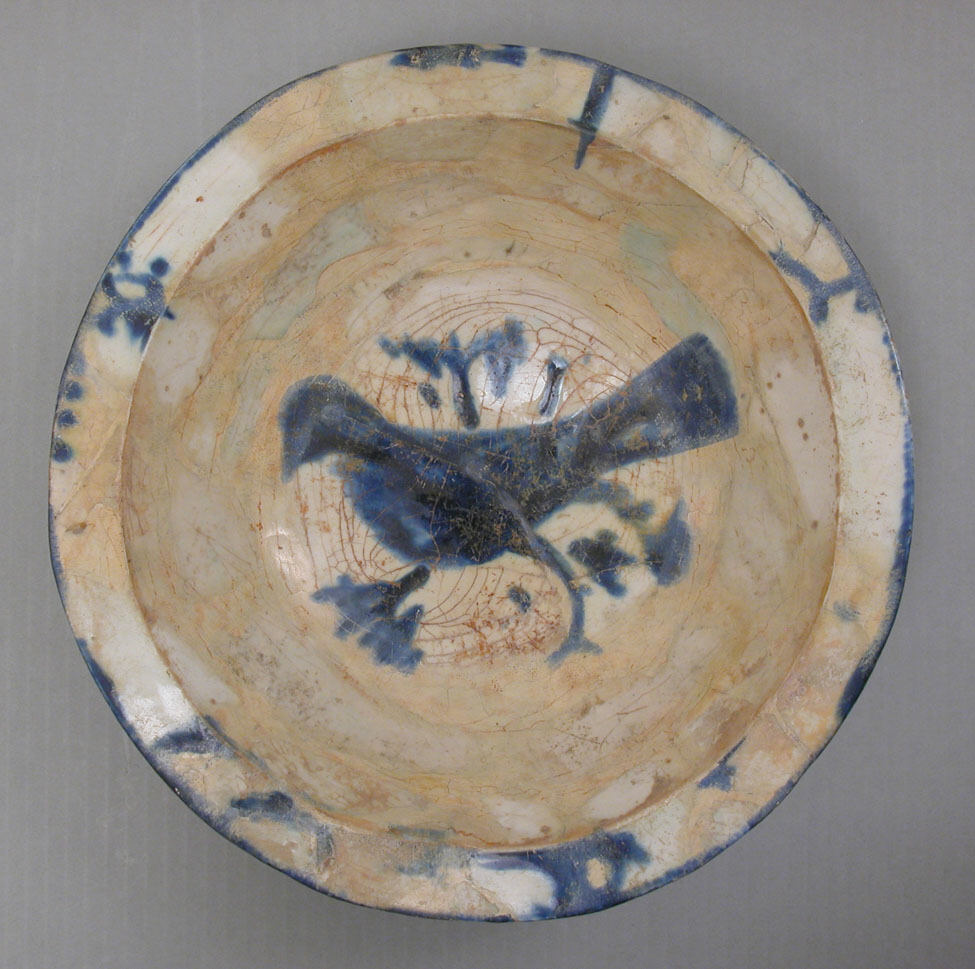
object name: bowl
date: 1101-1200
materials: earthenware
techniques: glazing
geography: syria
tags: birds